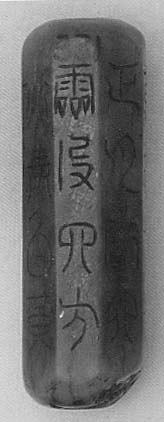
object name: signet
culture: chinese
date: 206 BCE-220 CE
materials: jade